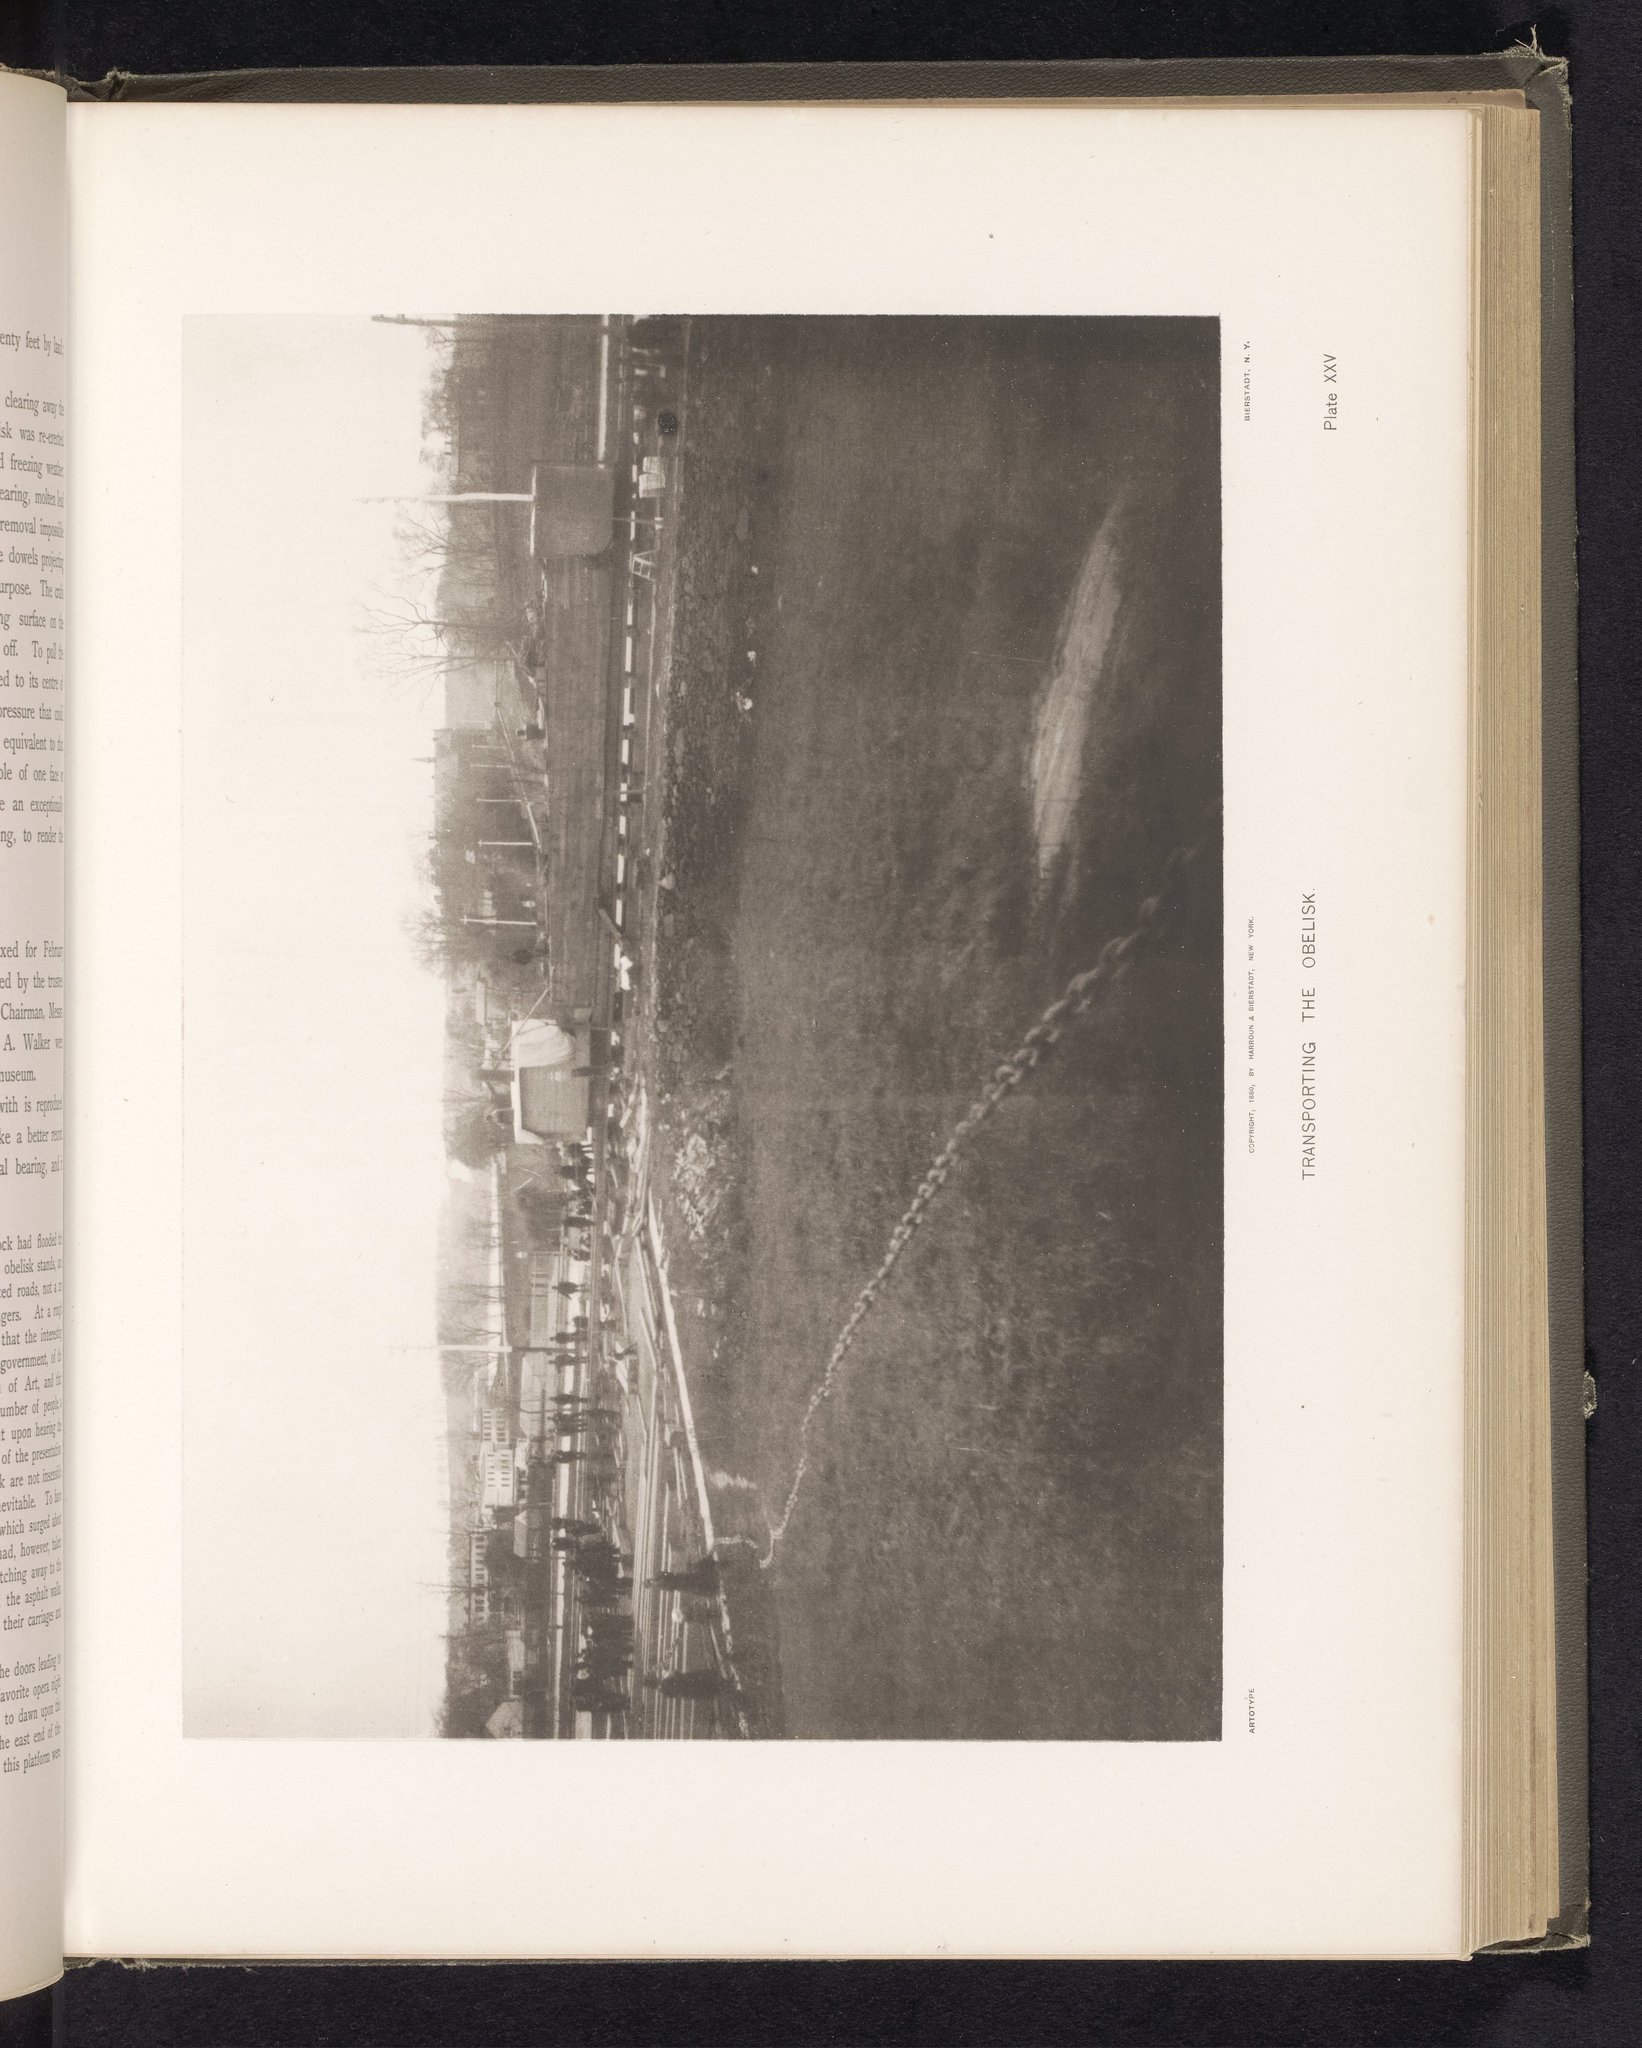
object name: page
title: Transporting the obelisk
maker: Anonymous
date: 1880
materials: paper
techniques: photograph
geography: new york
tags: obelisk, needle, traffic and transport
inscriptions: number: ‘Plate XXV’, inscription: ‘Copyright 1881, by HARROUN & BIERSTADT, New York’